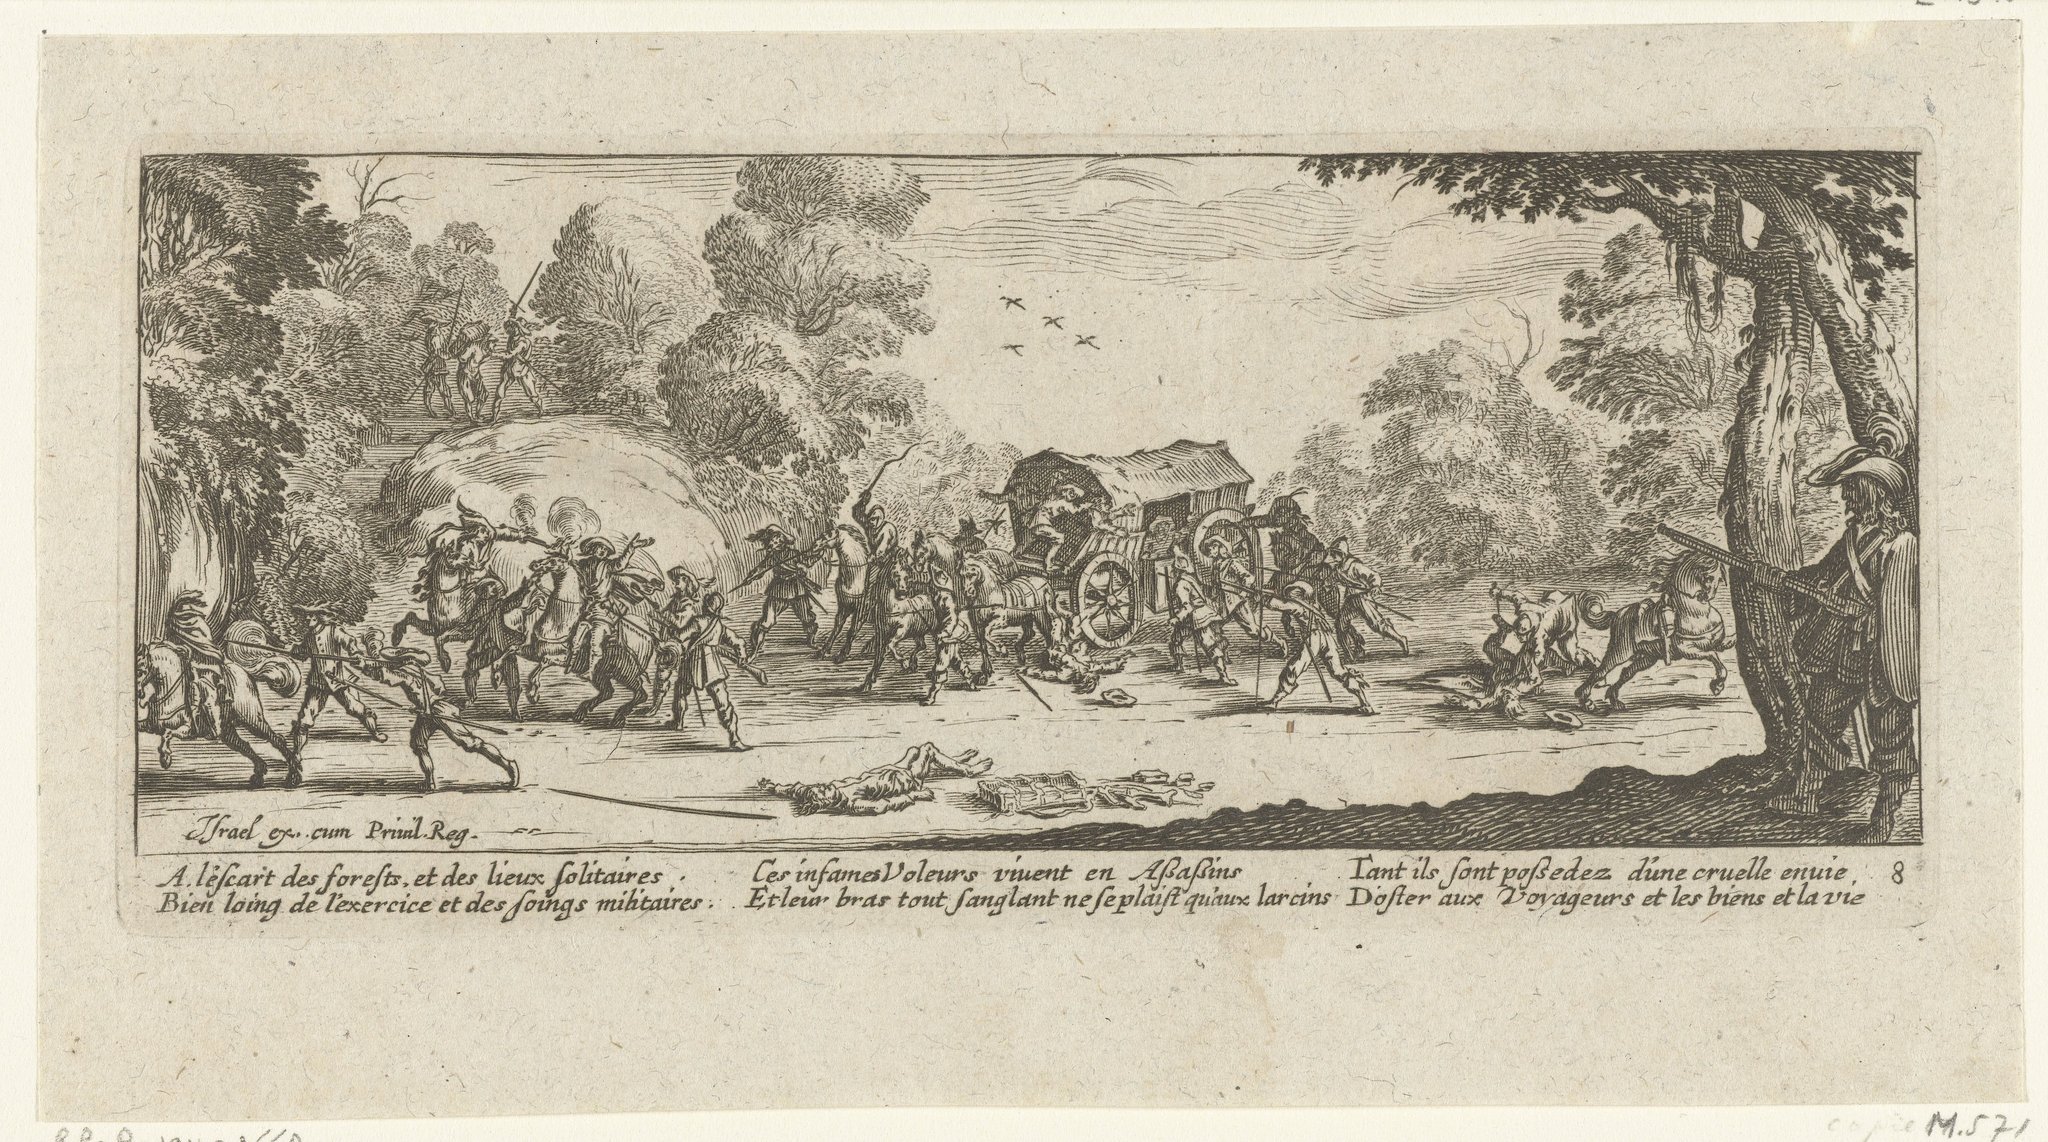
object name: print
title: Soldaten overvallen reizigers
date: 1677-1690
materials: paper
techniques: etching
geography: paris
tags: traveller(s) attacked by robber(s), plundering ~ soldiers, soldiers and civilians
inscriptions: collector's mark: Lugt 2228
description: Op een weg door een bos worden reizigers in een koets, ruiters en wandelaars met bepakking overvallen door soldaten. Onder de voorstelling een zesregelig Frans vers. Deze prent is onderdeel van een serie van 17 (18 incl. titelprent) prenten met voorstellingen van diverse soorten ellende die oorlogvoering met zich meebrengt.